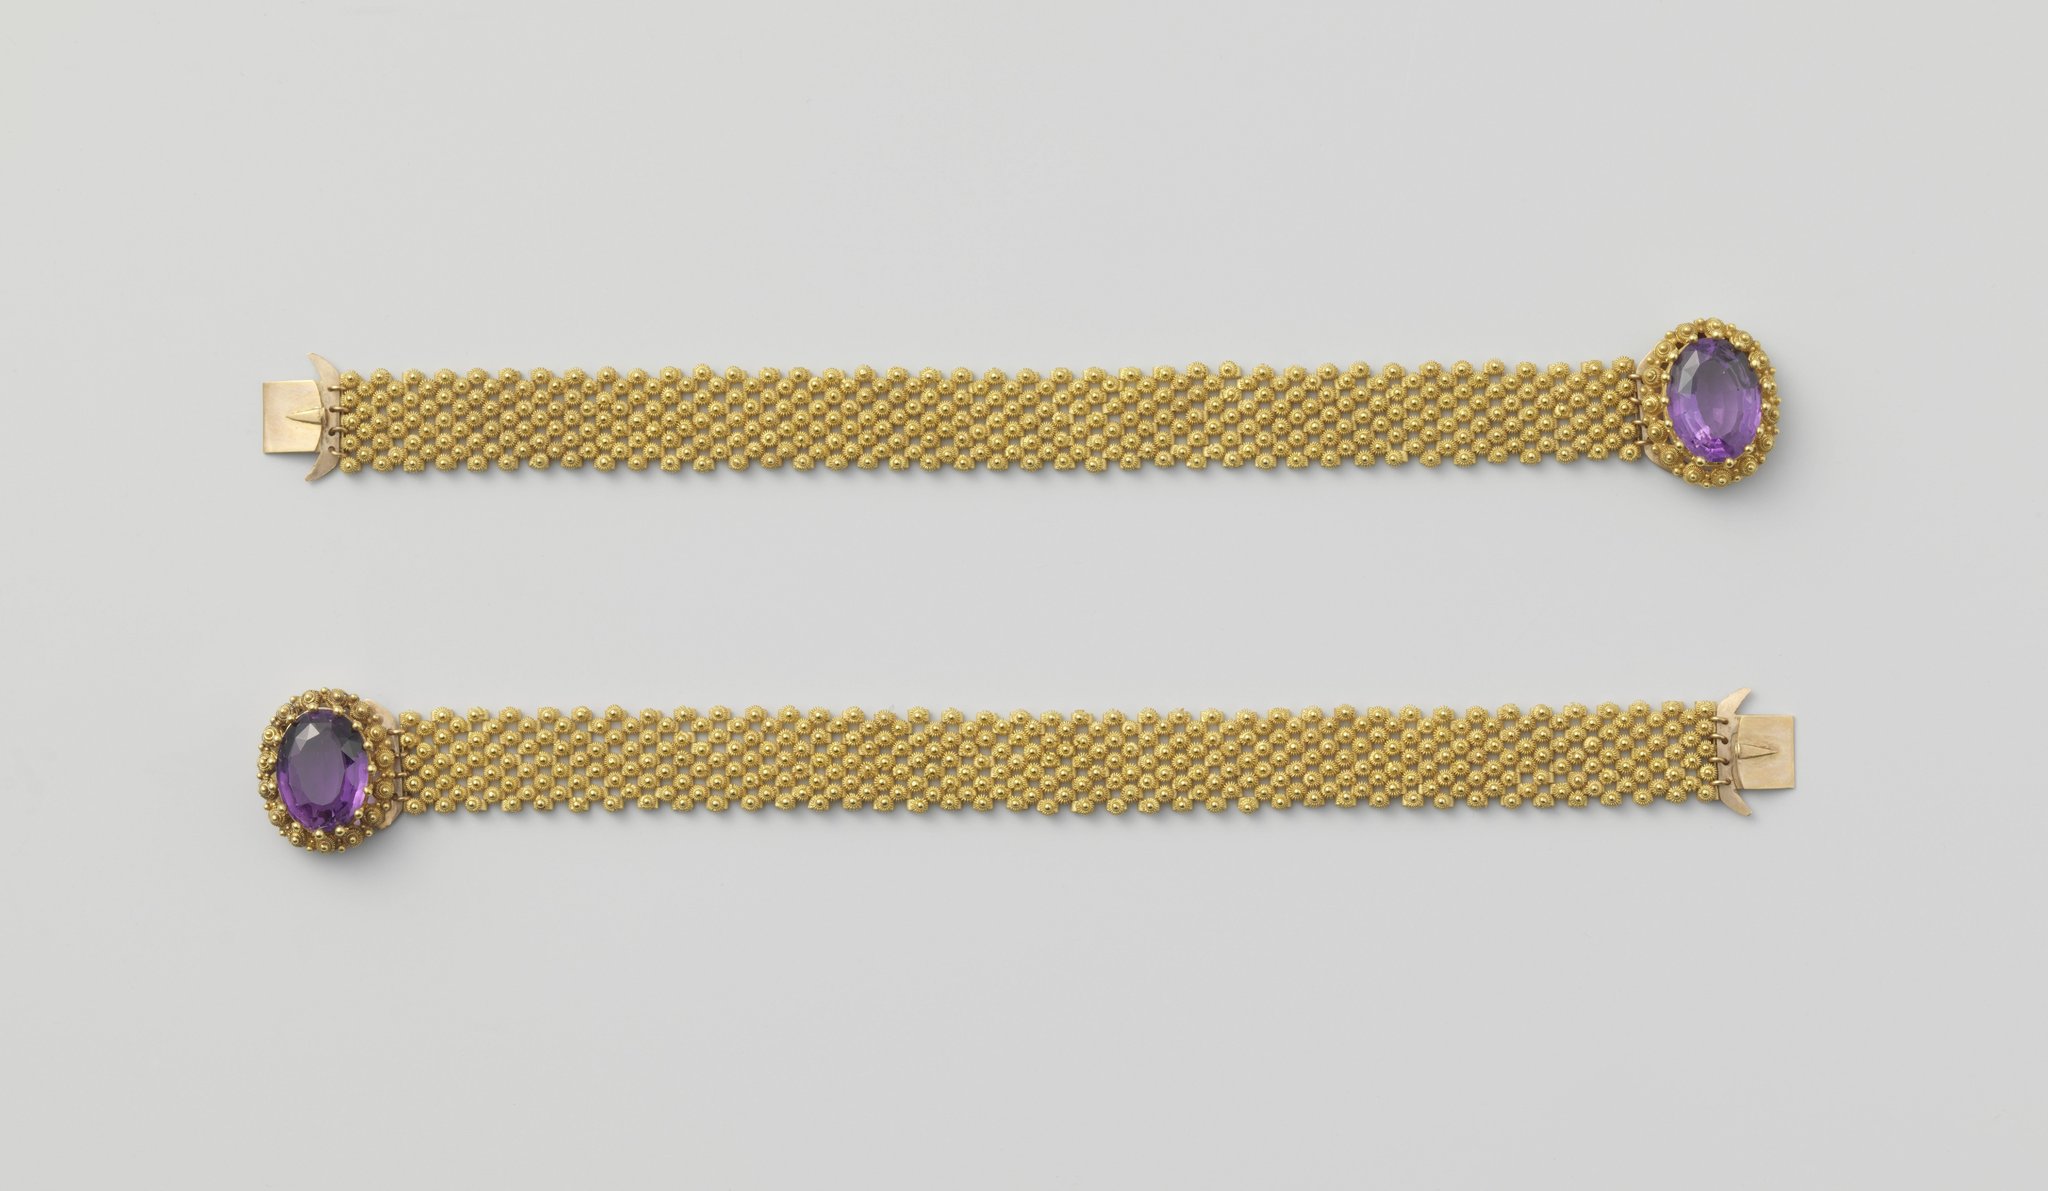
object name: bracelet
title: Armband van goud en amethist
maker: jean baptiste bonnard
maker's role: goldsmith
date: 1824-1829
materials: gemstone, gold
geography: amsterdam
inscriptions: alloy mark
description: Parure. Gold and amethyst. Amsterdam, c. 1824 - 1829, by Jean Baptiste Bonnard.